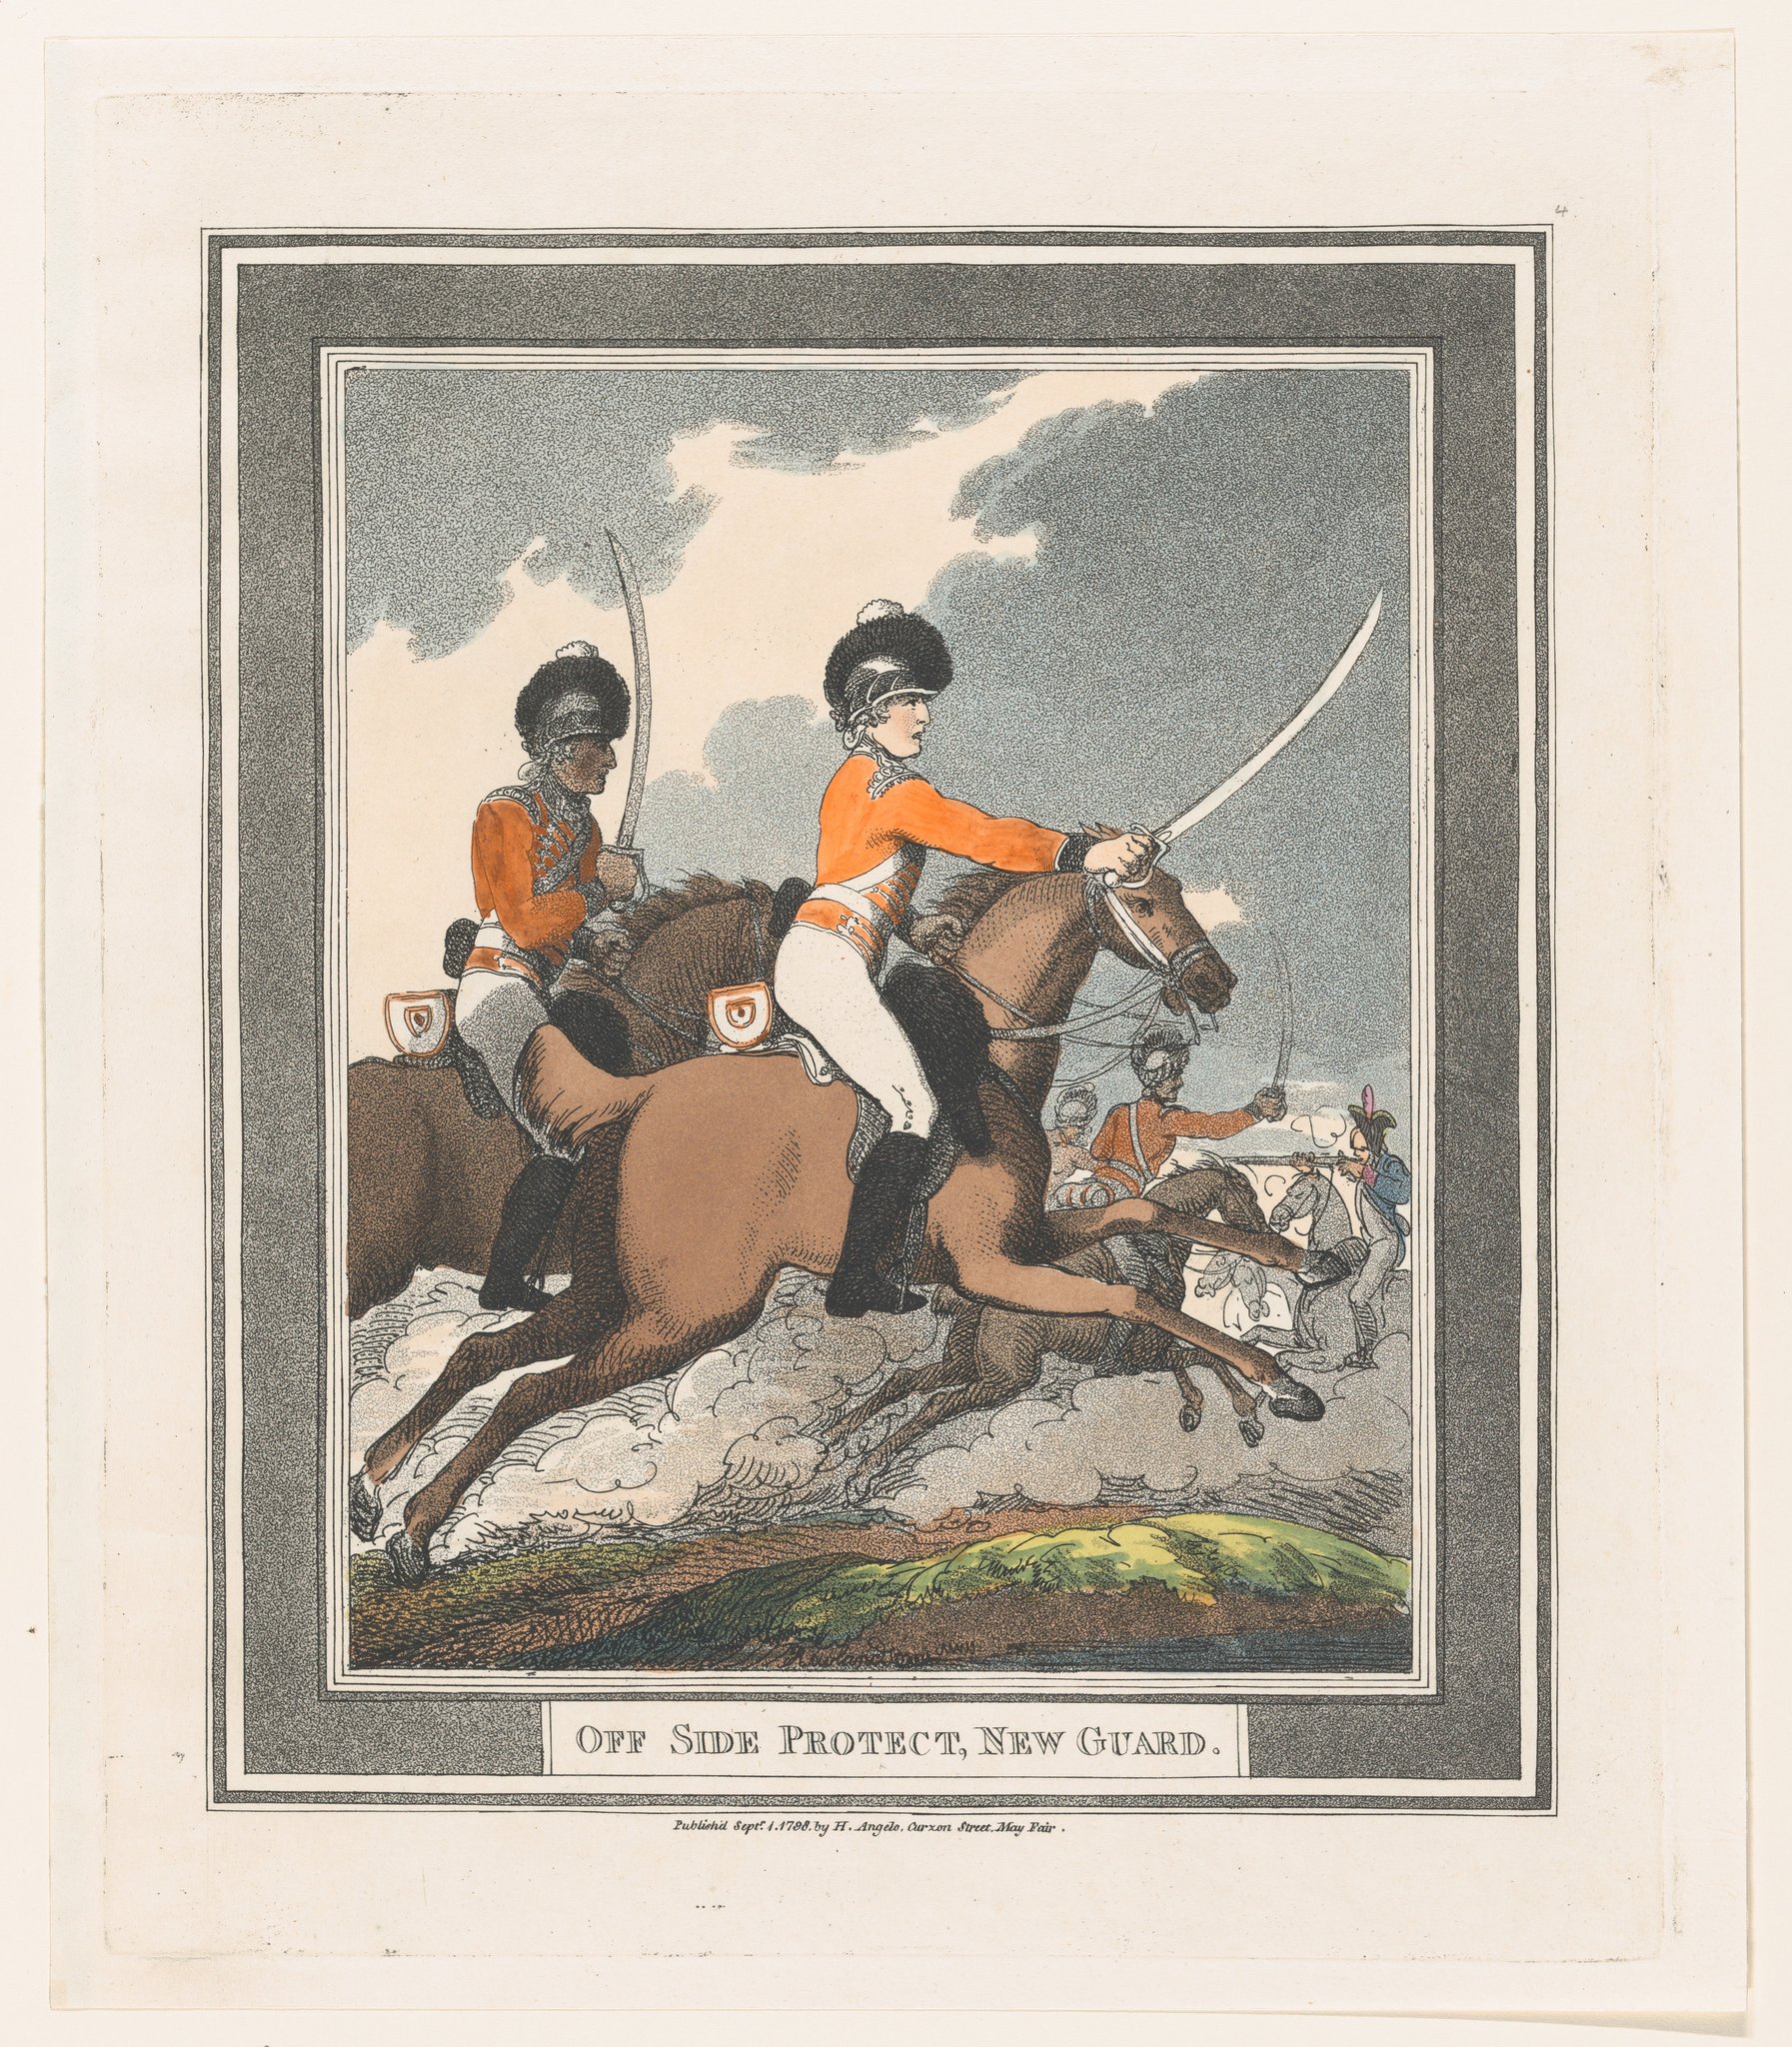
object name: print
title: Off Side Protect, New Guard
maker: thomas rowlandson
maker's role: artist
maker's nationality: british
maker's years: 1757-1827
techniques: aquatint, etching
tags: battles,soldiers,men,horses